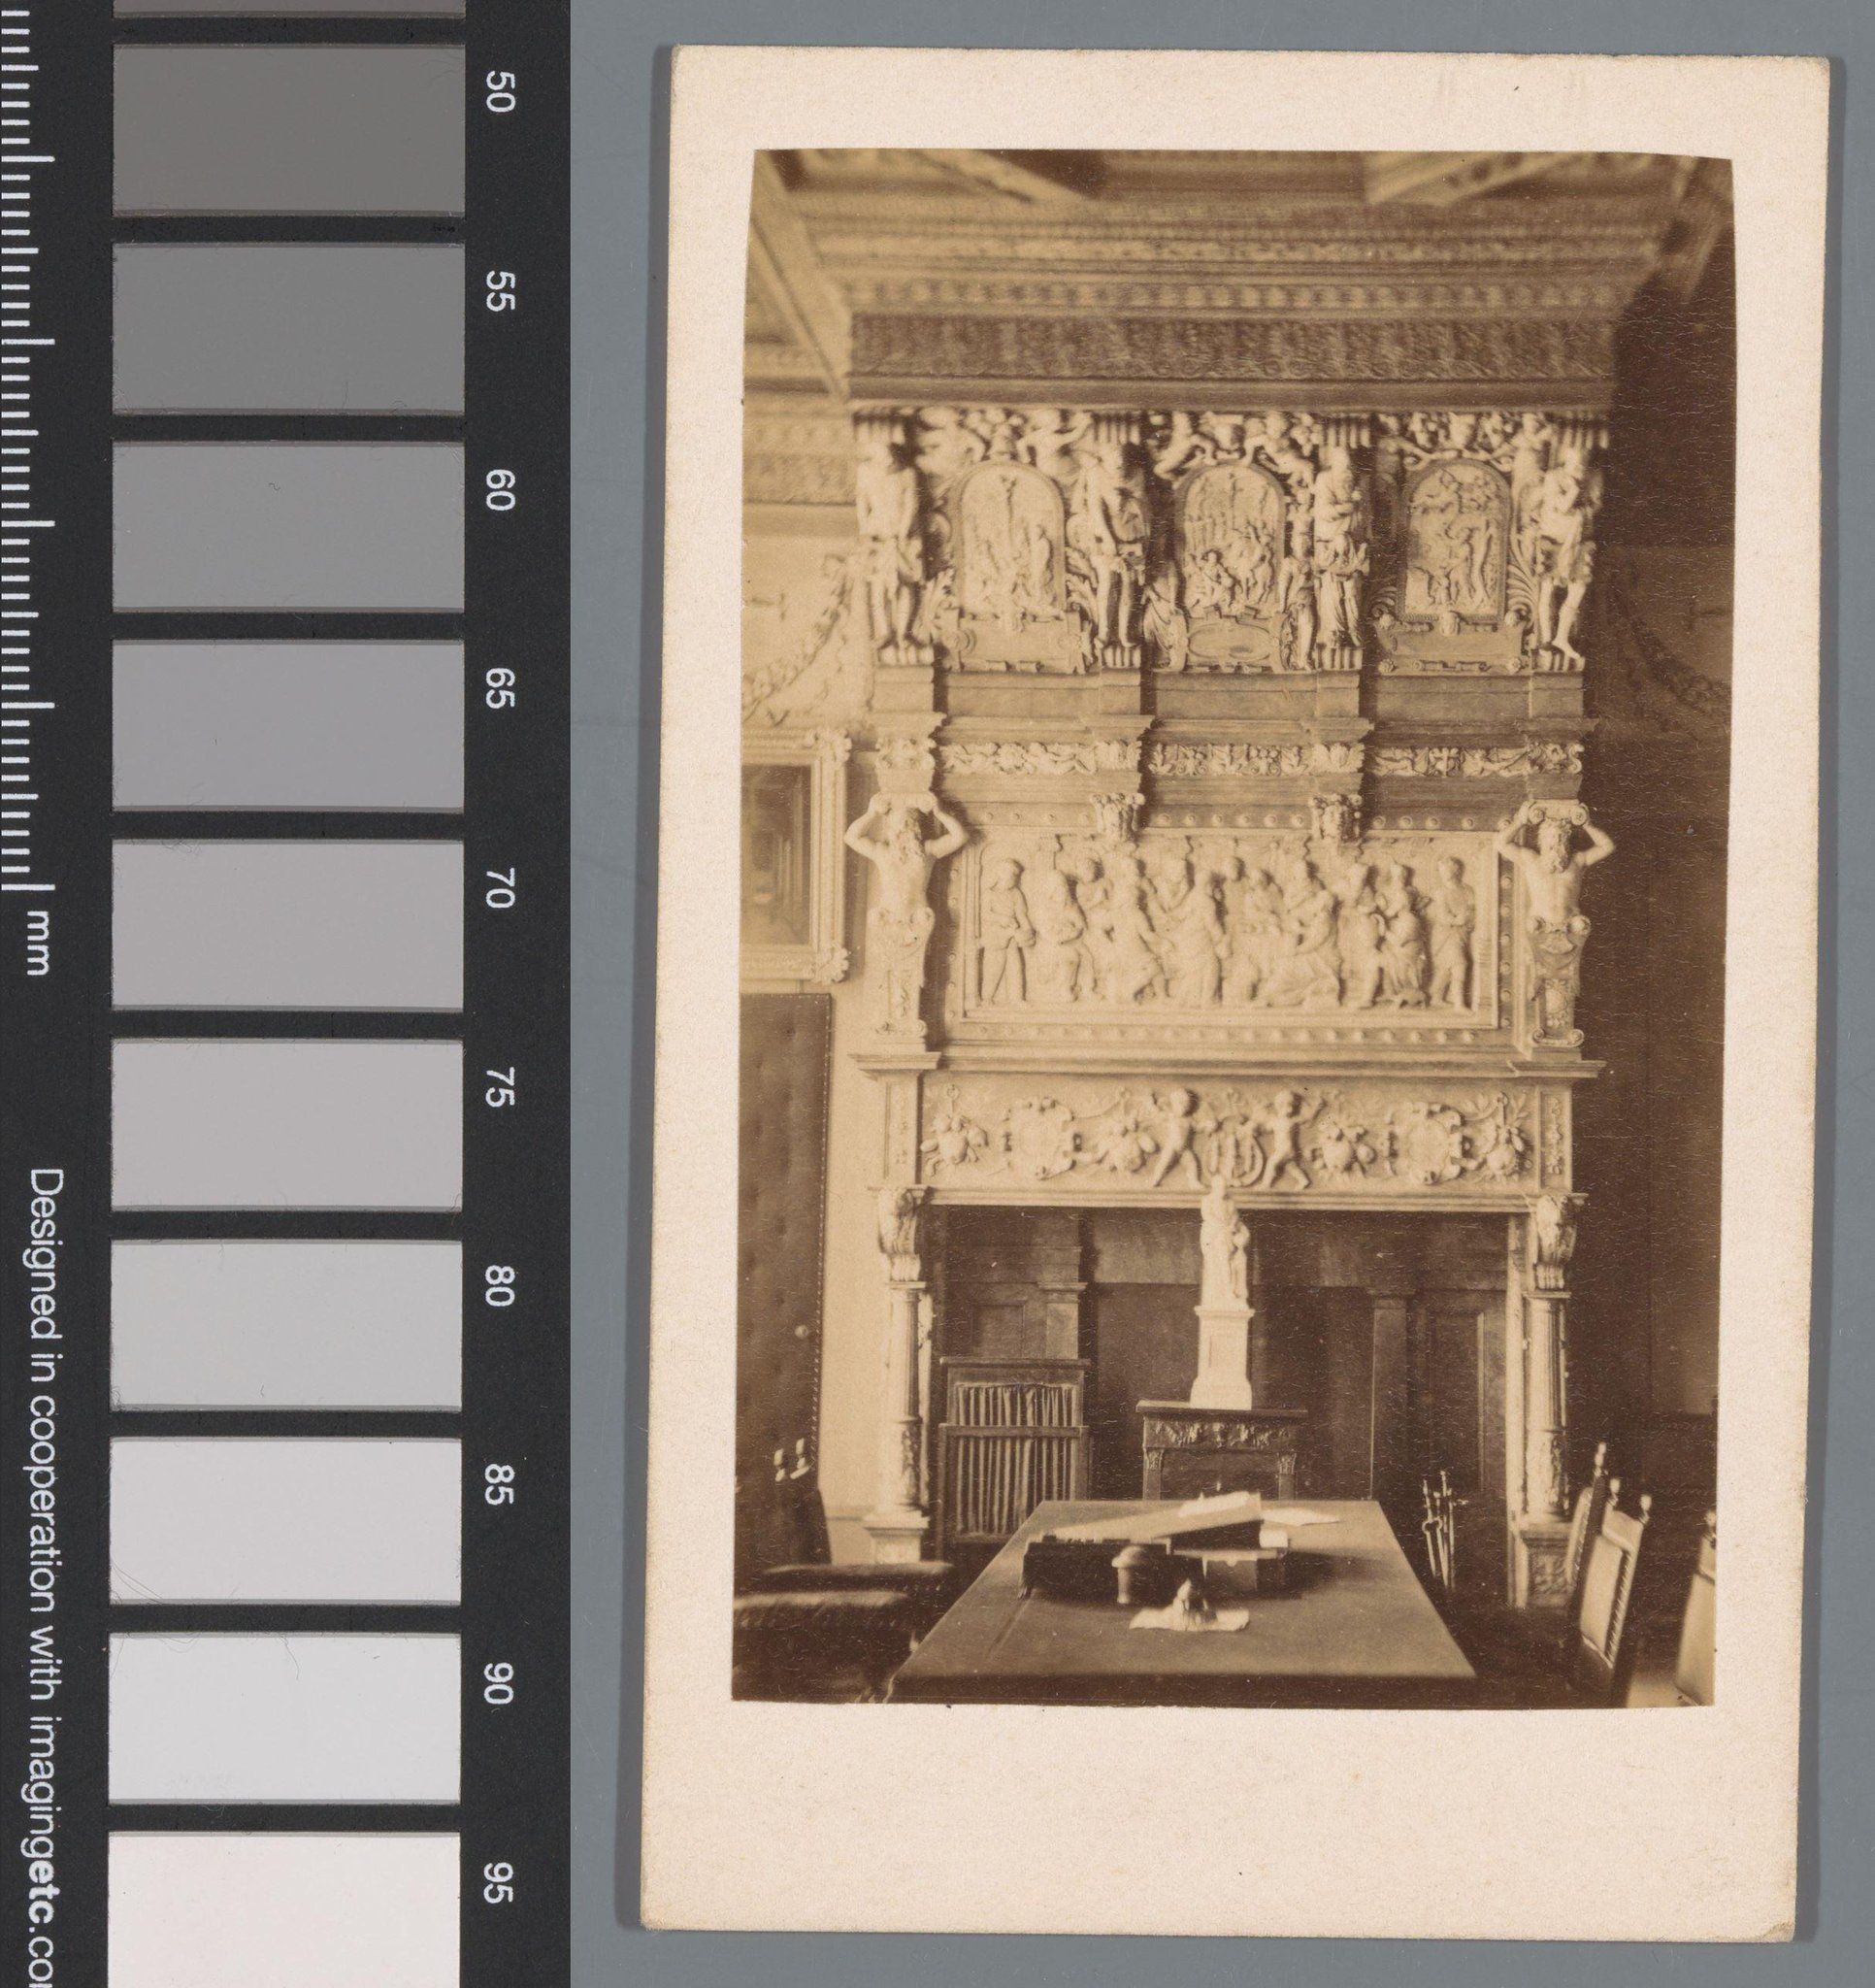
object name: photograph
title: Vues d'Anvers. / Views of Antwerp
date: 1855-1885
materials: cardboard, paper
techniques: albumen print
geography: antwerp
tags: chimney-piece, mantelpiece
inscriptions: number: ‘(24)’